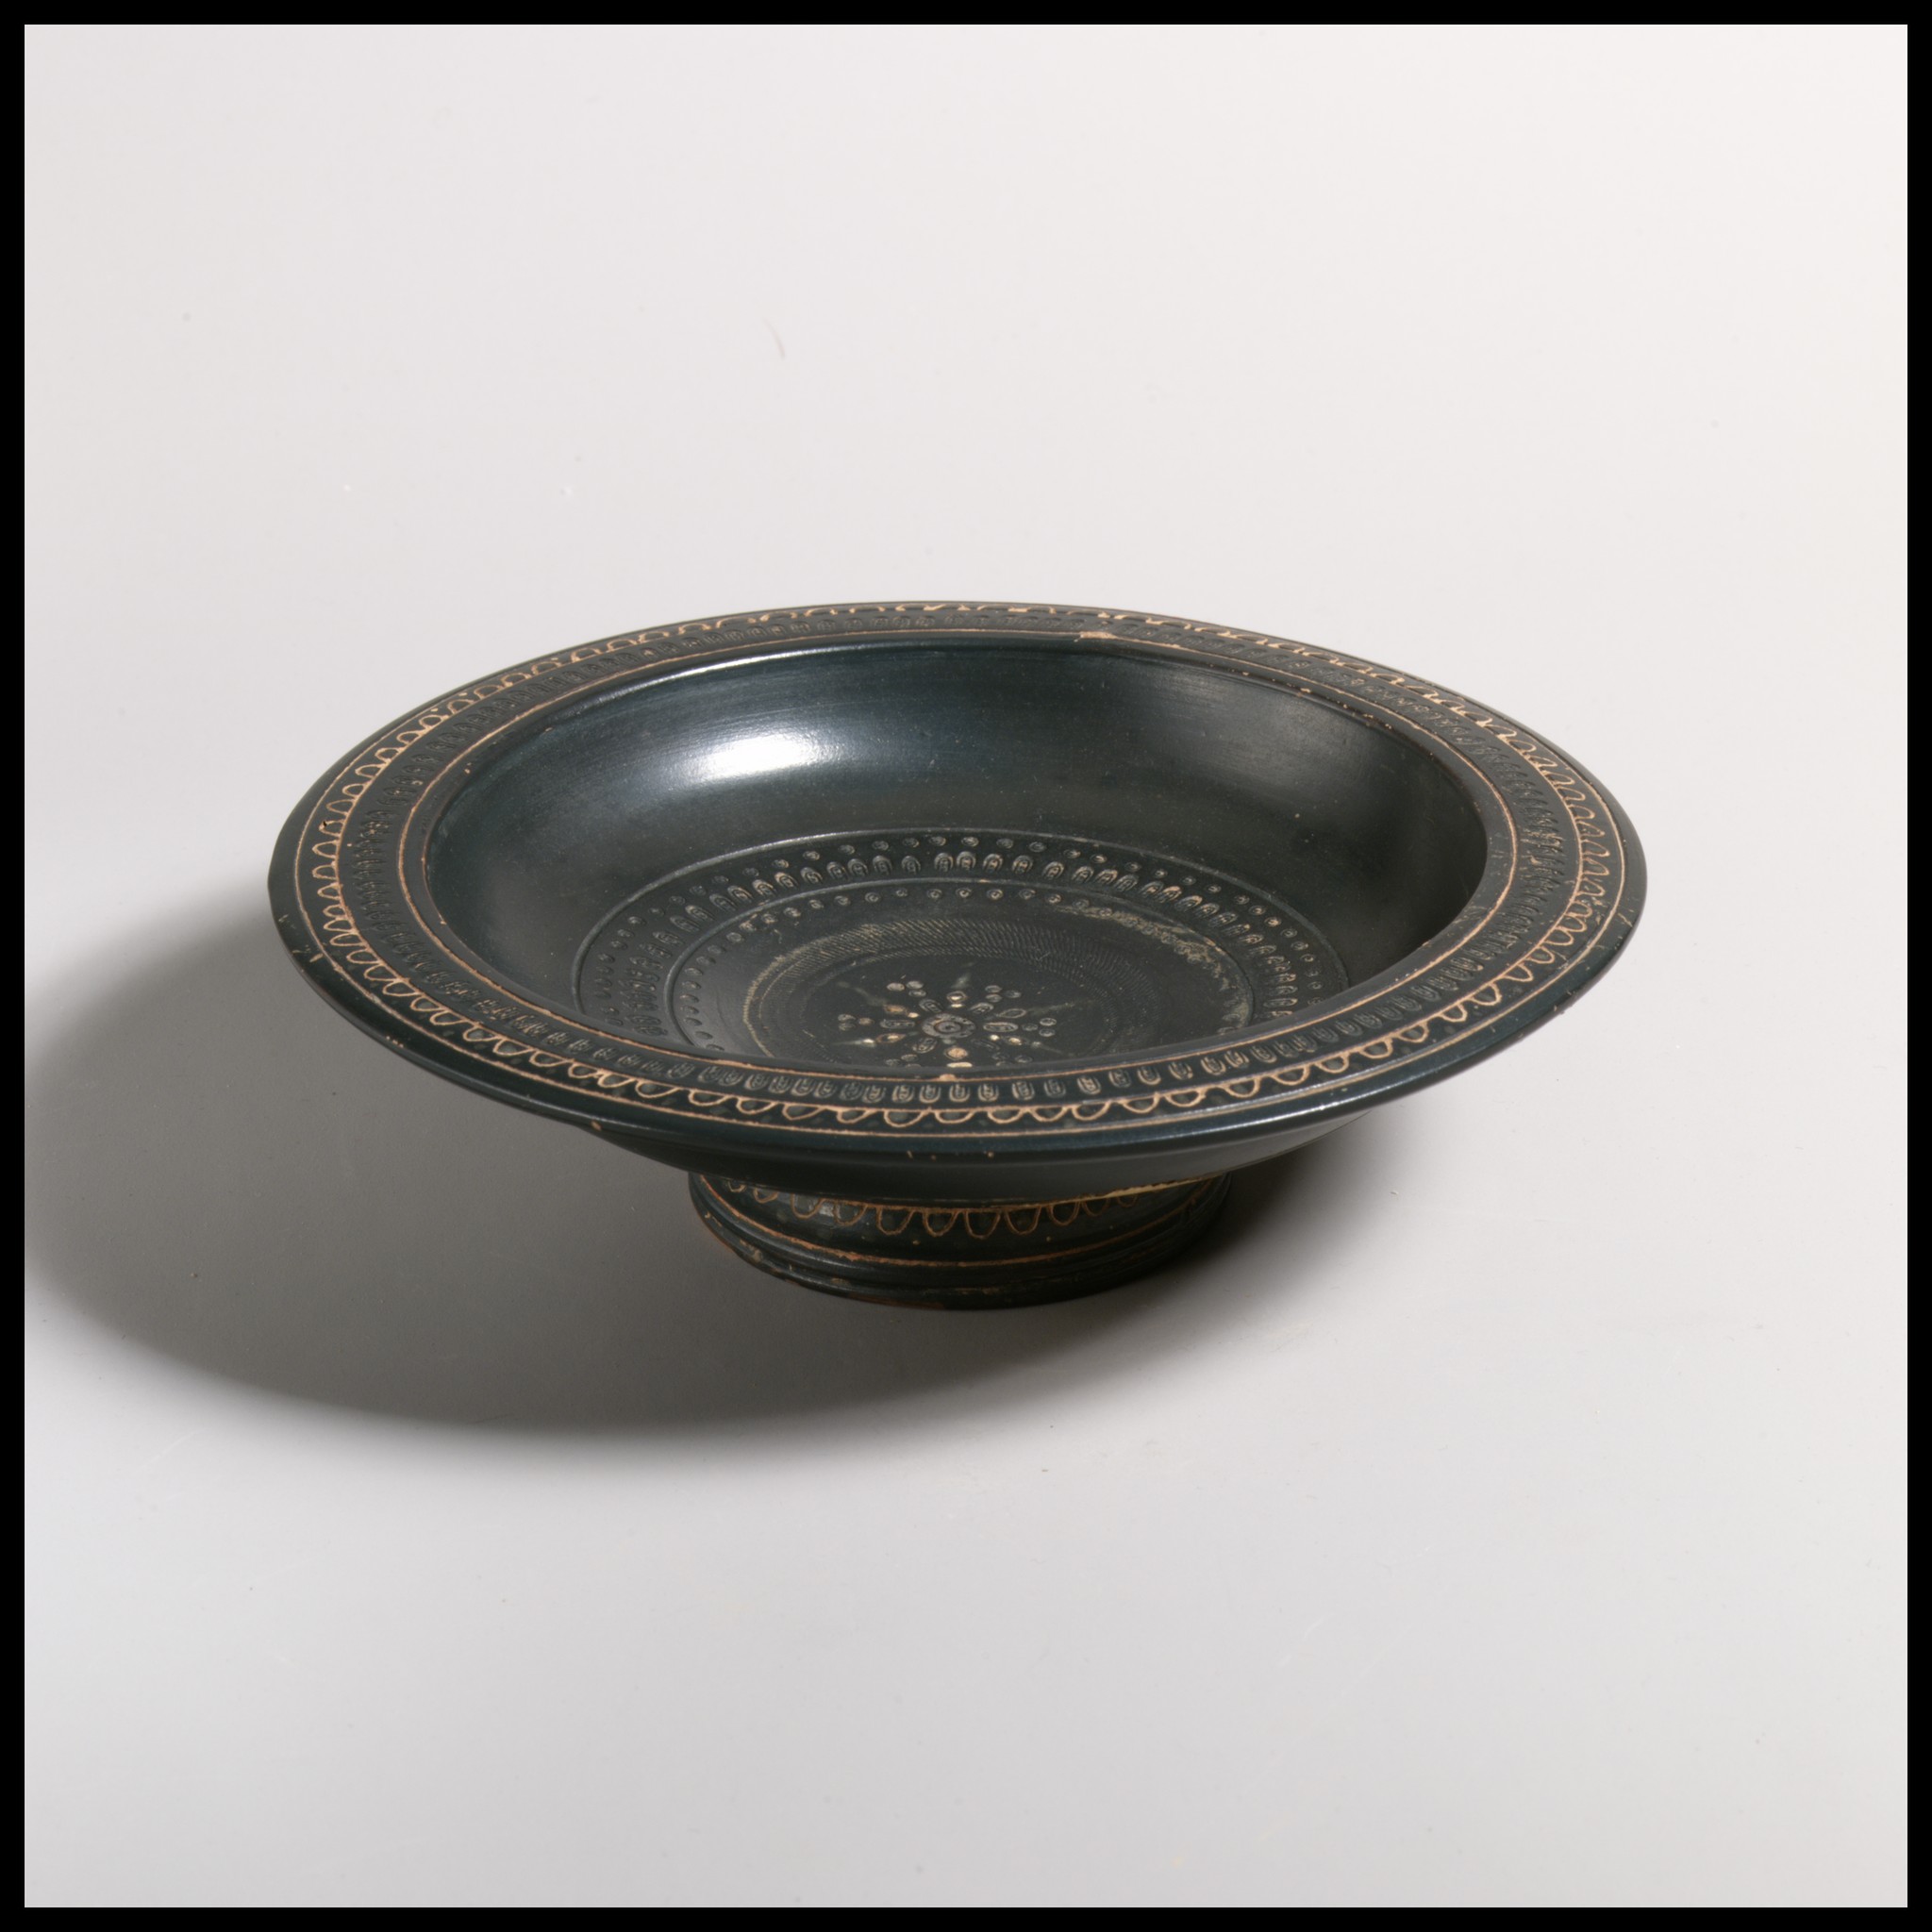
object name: dish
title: Terracotta dish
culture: greek, south italian, campanian, teano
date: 330-300 BCE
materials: terracotta